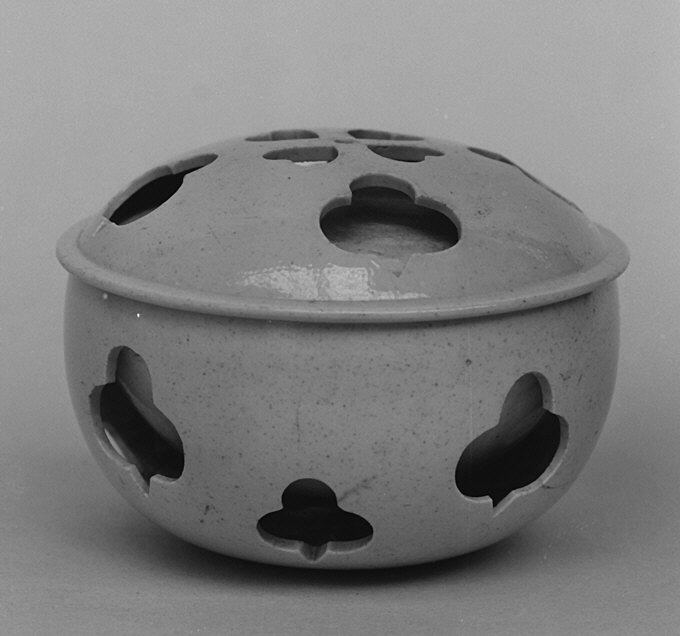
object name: pomade box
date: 1701-1800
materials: stoneware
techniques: salt glaze